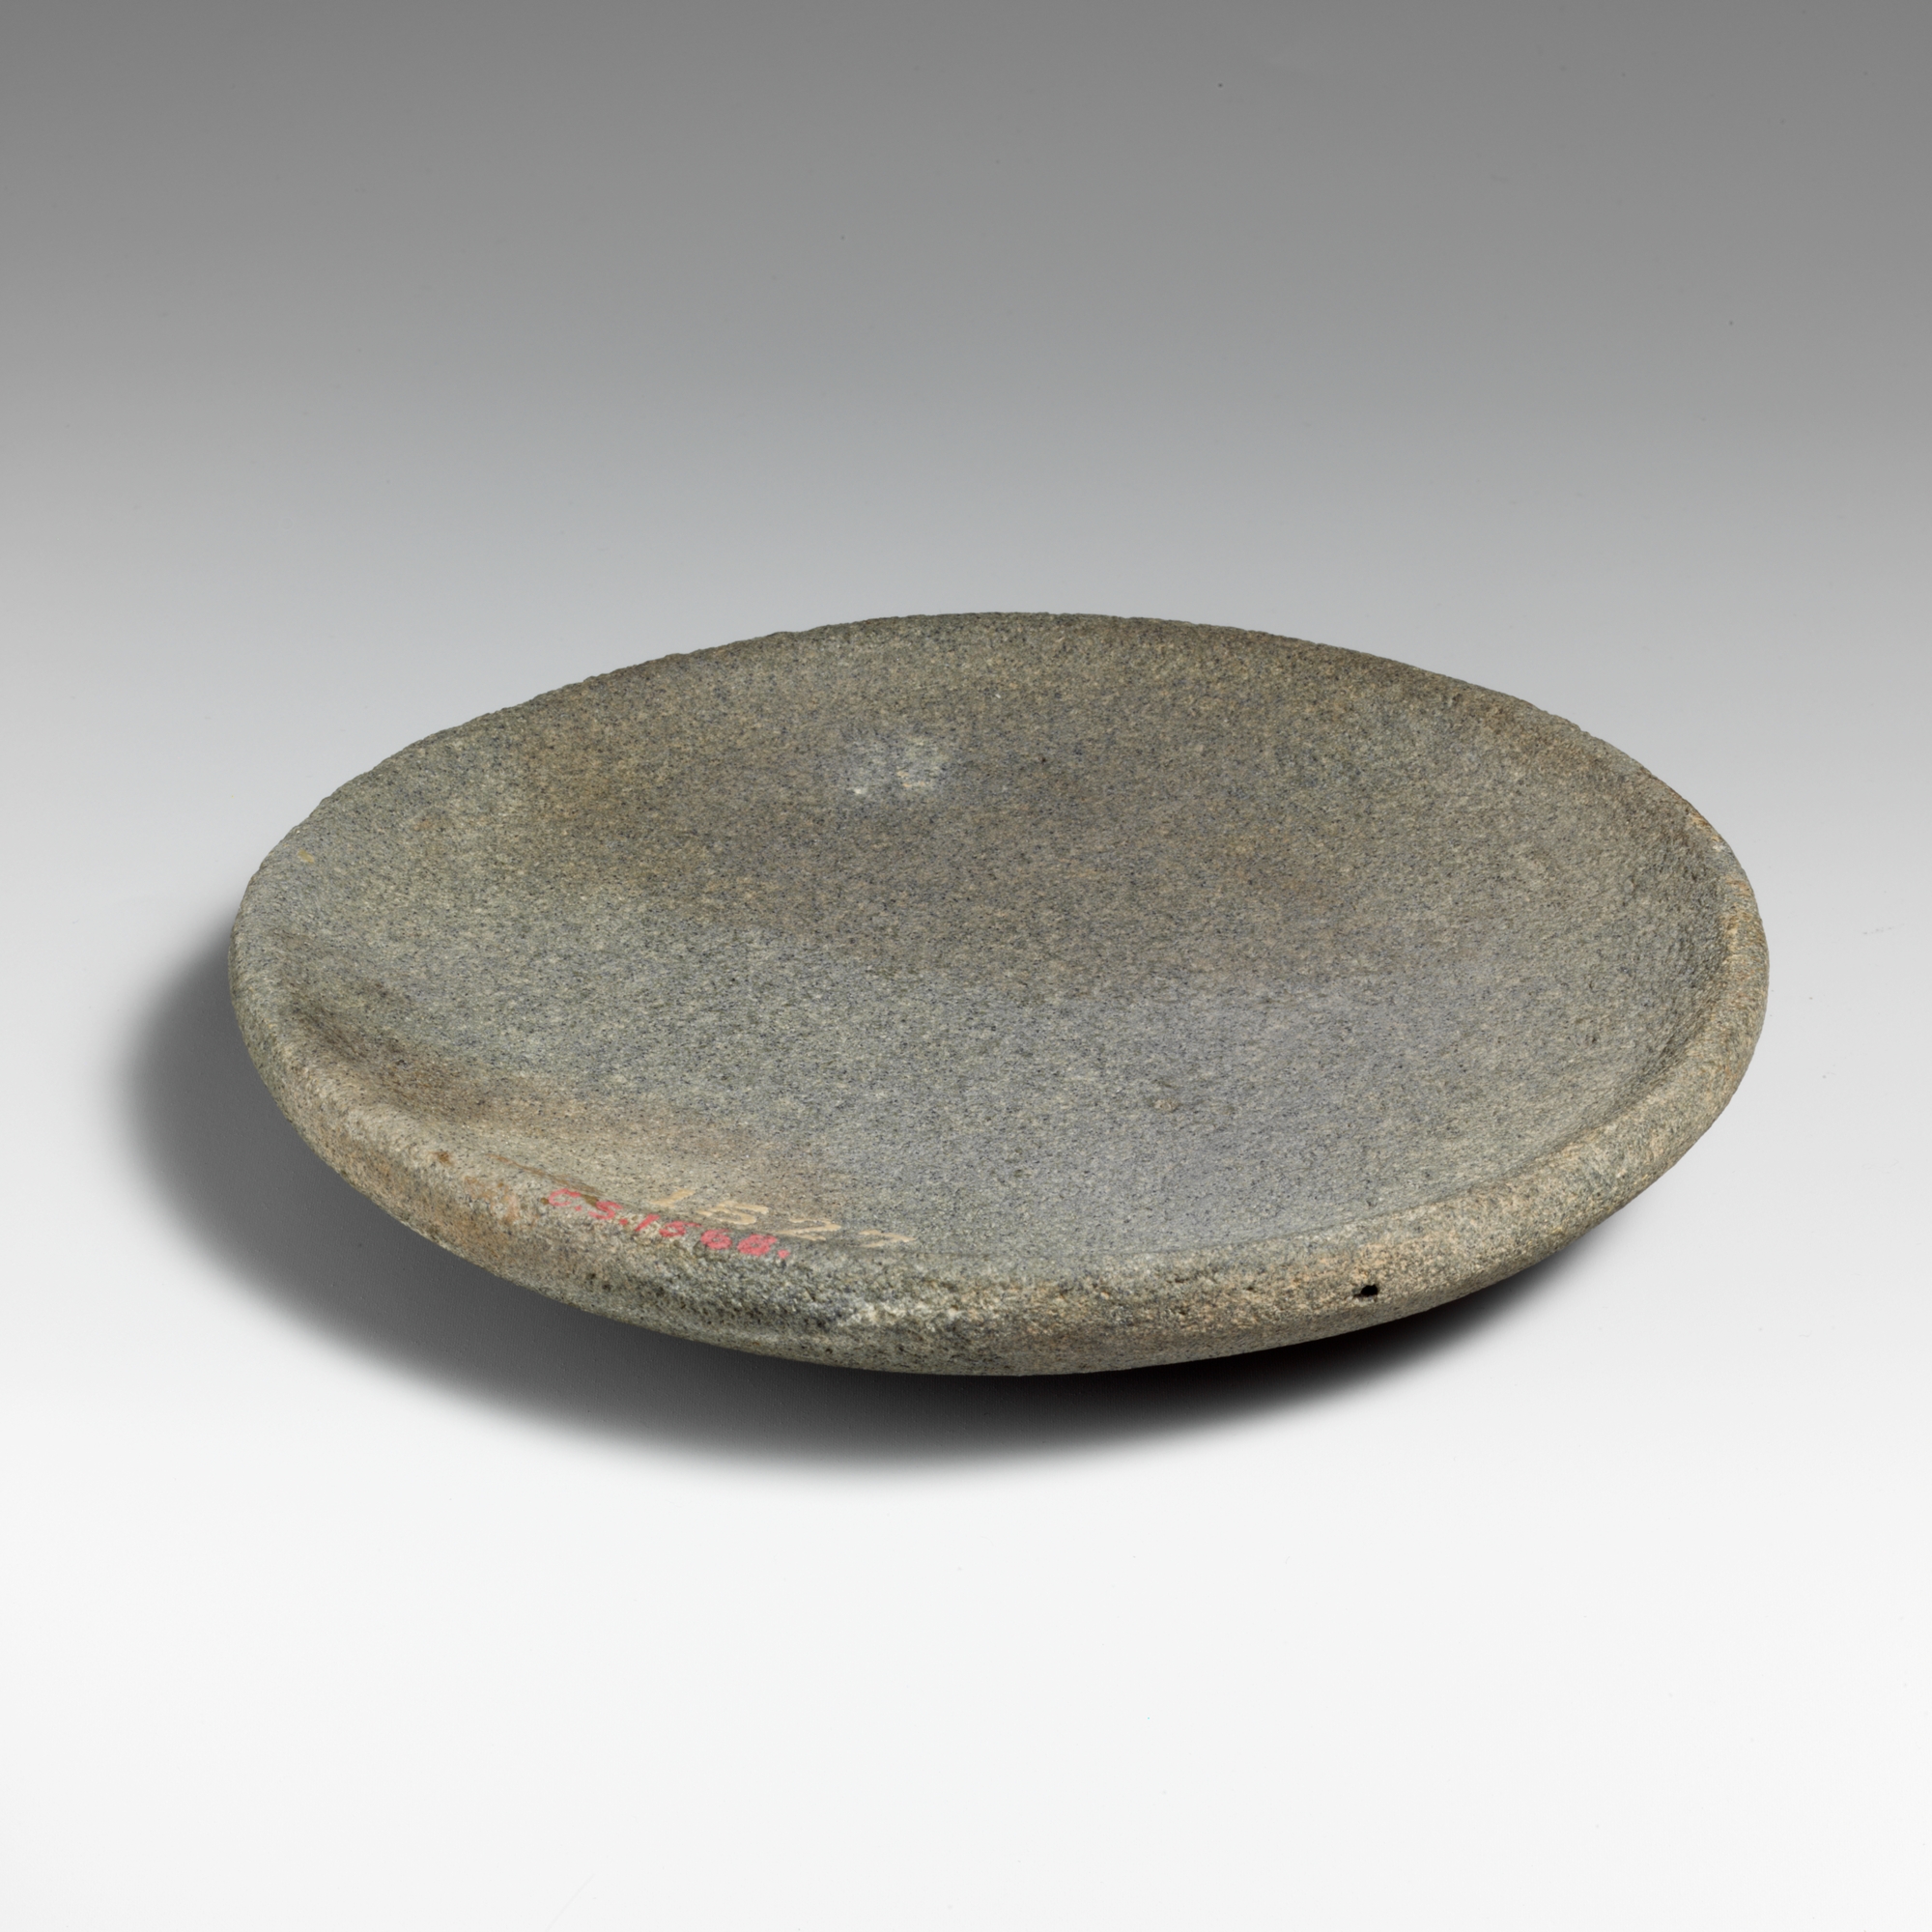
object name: plate or palette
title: Basalt mortar or plate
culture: cypriot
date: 1600-1050 BCE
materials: stone